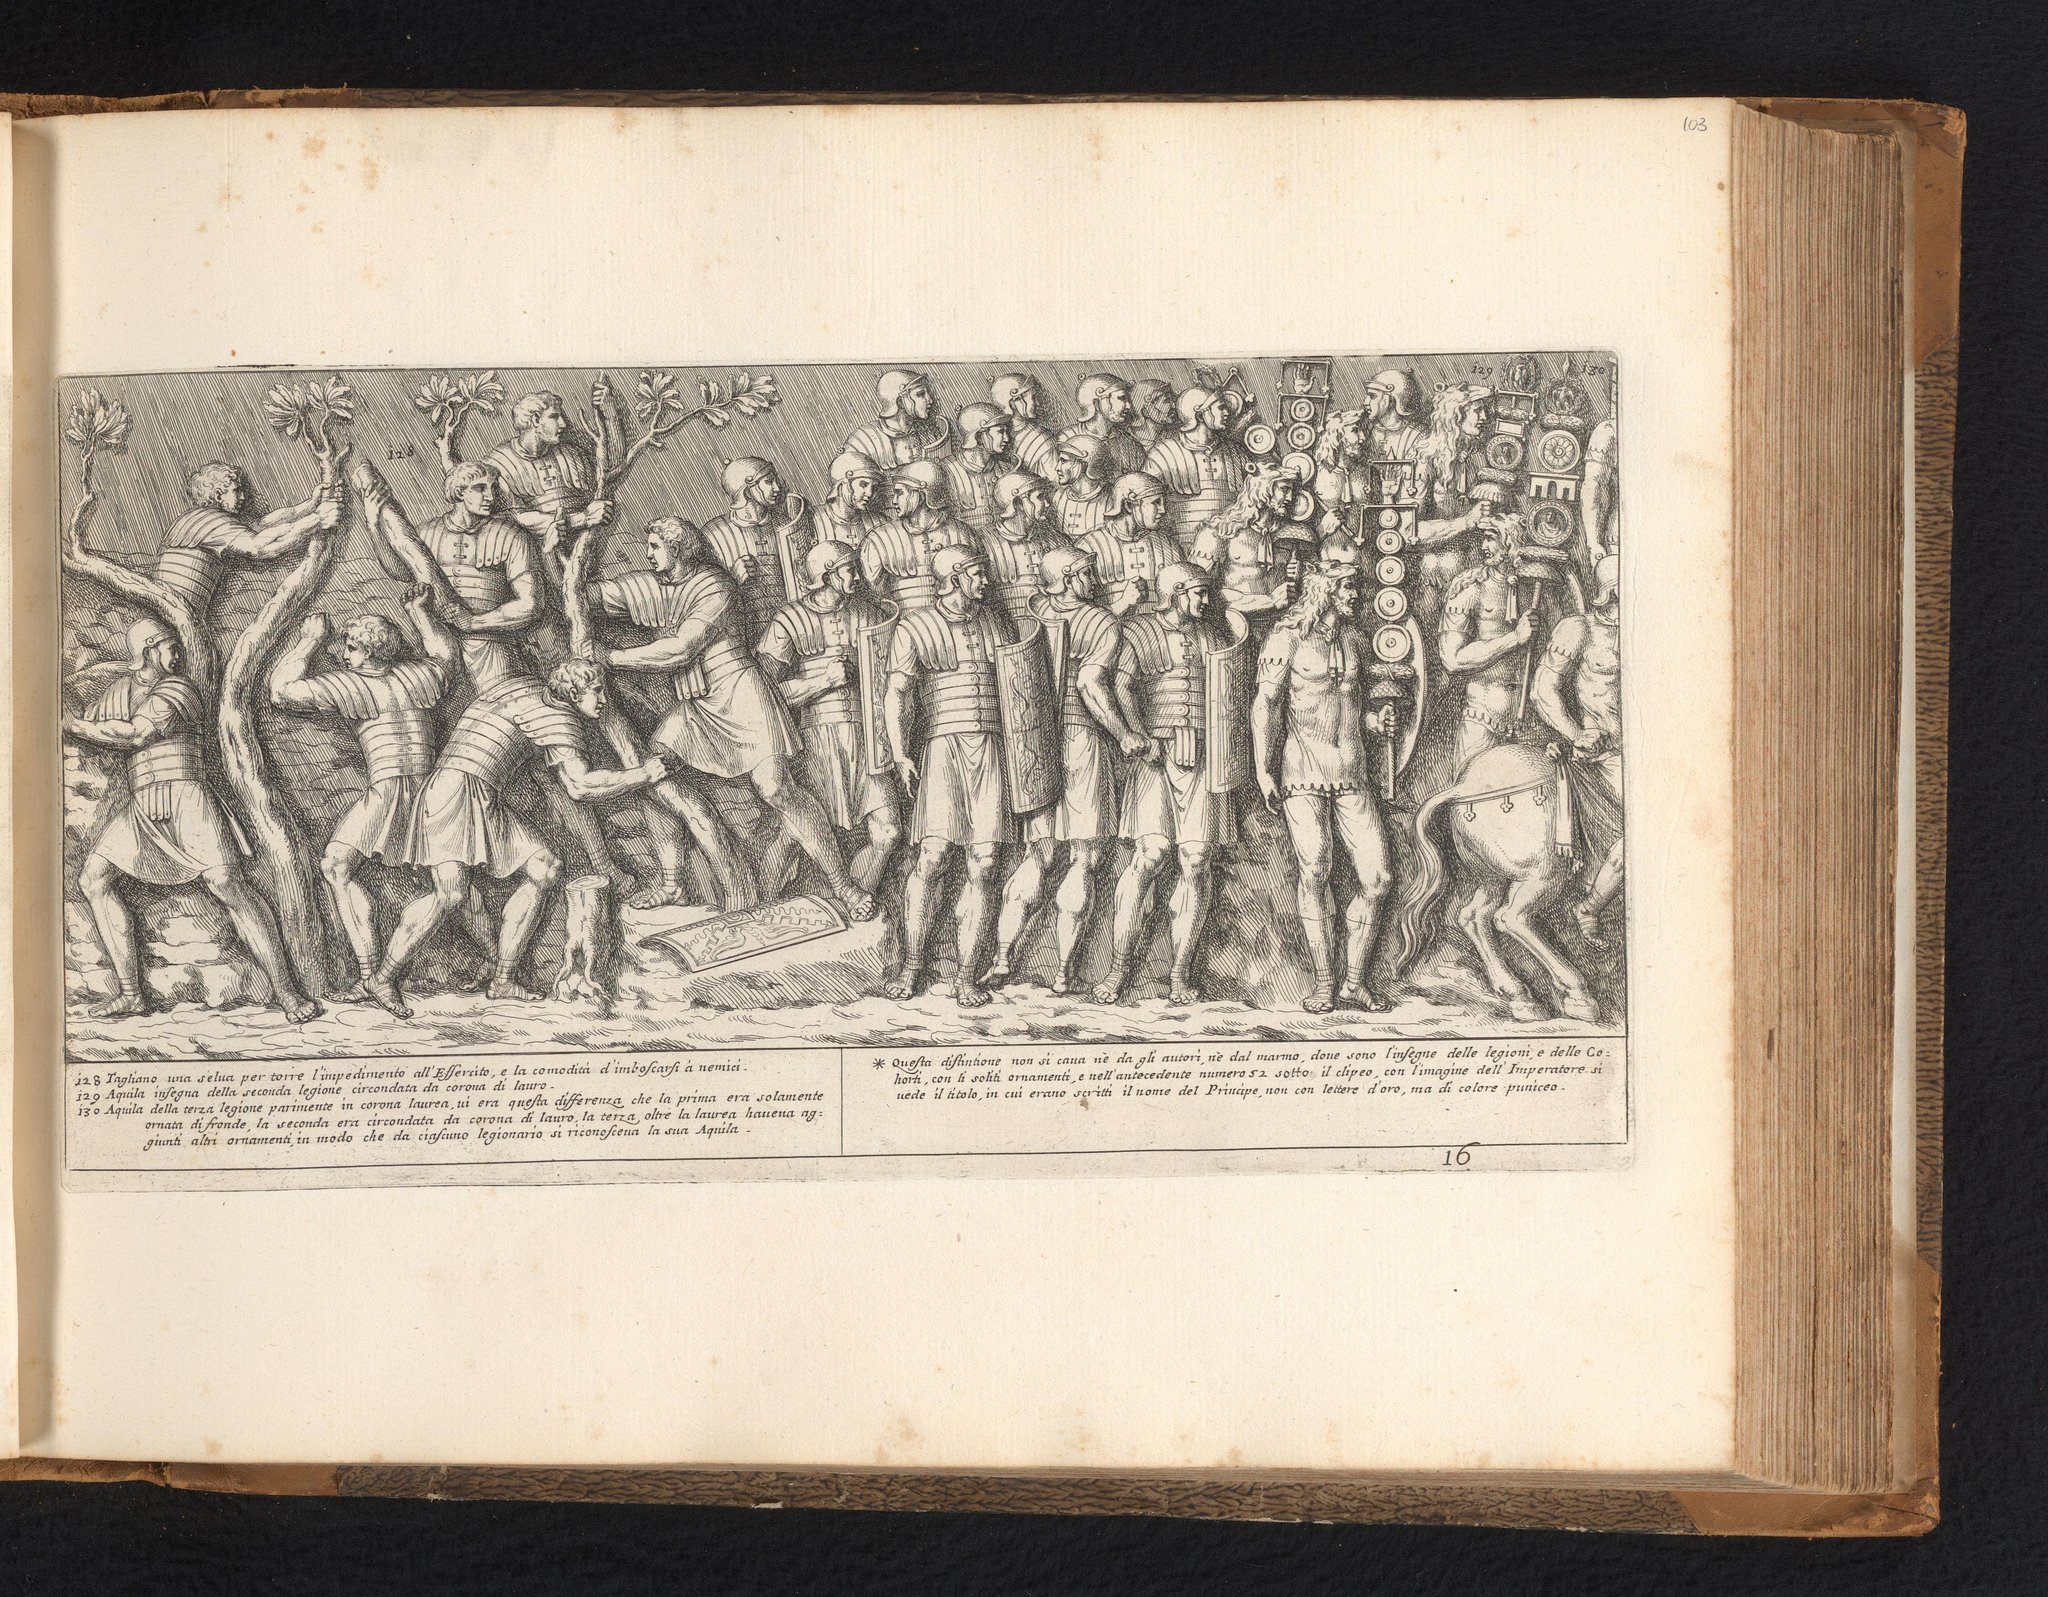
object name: album leaf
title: Zuil van Trajanus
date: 1637-1691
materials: paper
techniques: etching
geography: rome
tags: triumphal column with helical friezes, piece of sculpture, reproduction of a piece of sculpture, the soldier; the soldier's life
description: Detail van het spiraalvormige gebeeldhouwde fries op de Zuil van Trajanus. Het fries toont de oorlogen tussen de Romeinen en de Daciërs. Verklarende nummers in de ondermarge. Prent maakt deel uit van een album.